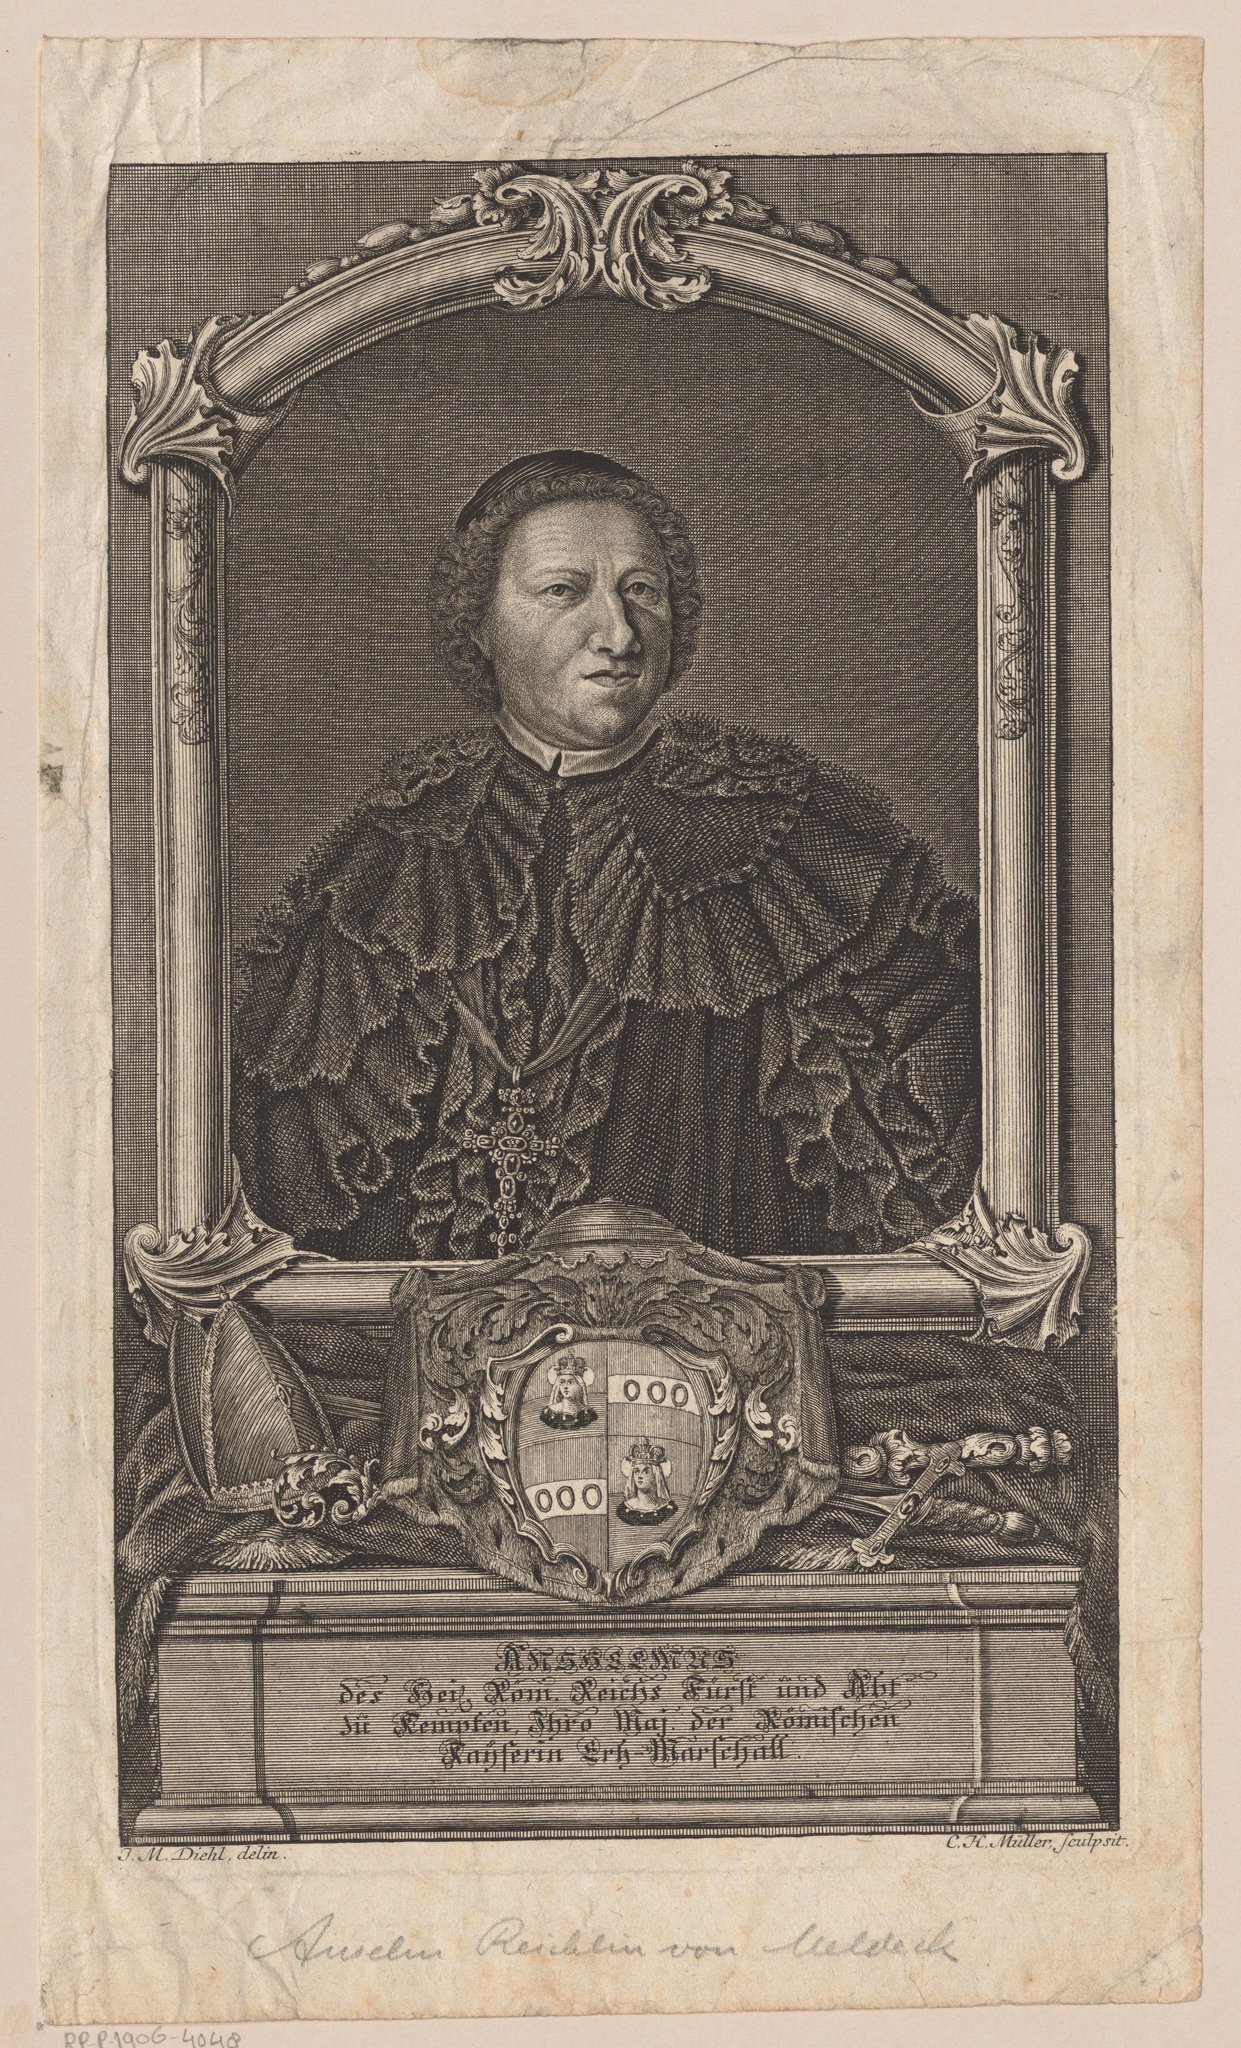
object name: print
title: Portret van Anselm Reichlin von Meldegg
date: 1742-1799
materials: paper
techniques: engraving, etching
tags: historical persons, armorial bearing, heraldry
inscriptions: collector's mark: Lugt 2228